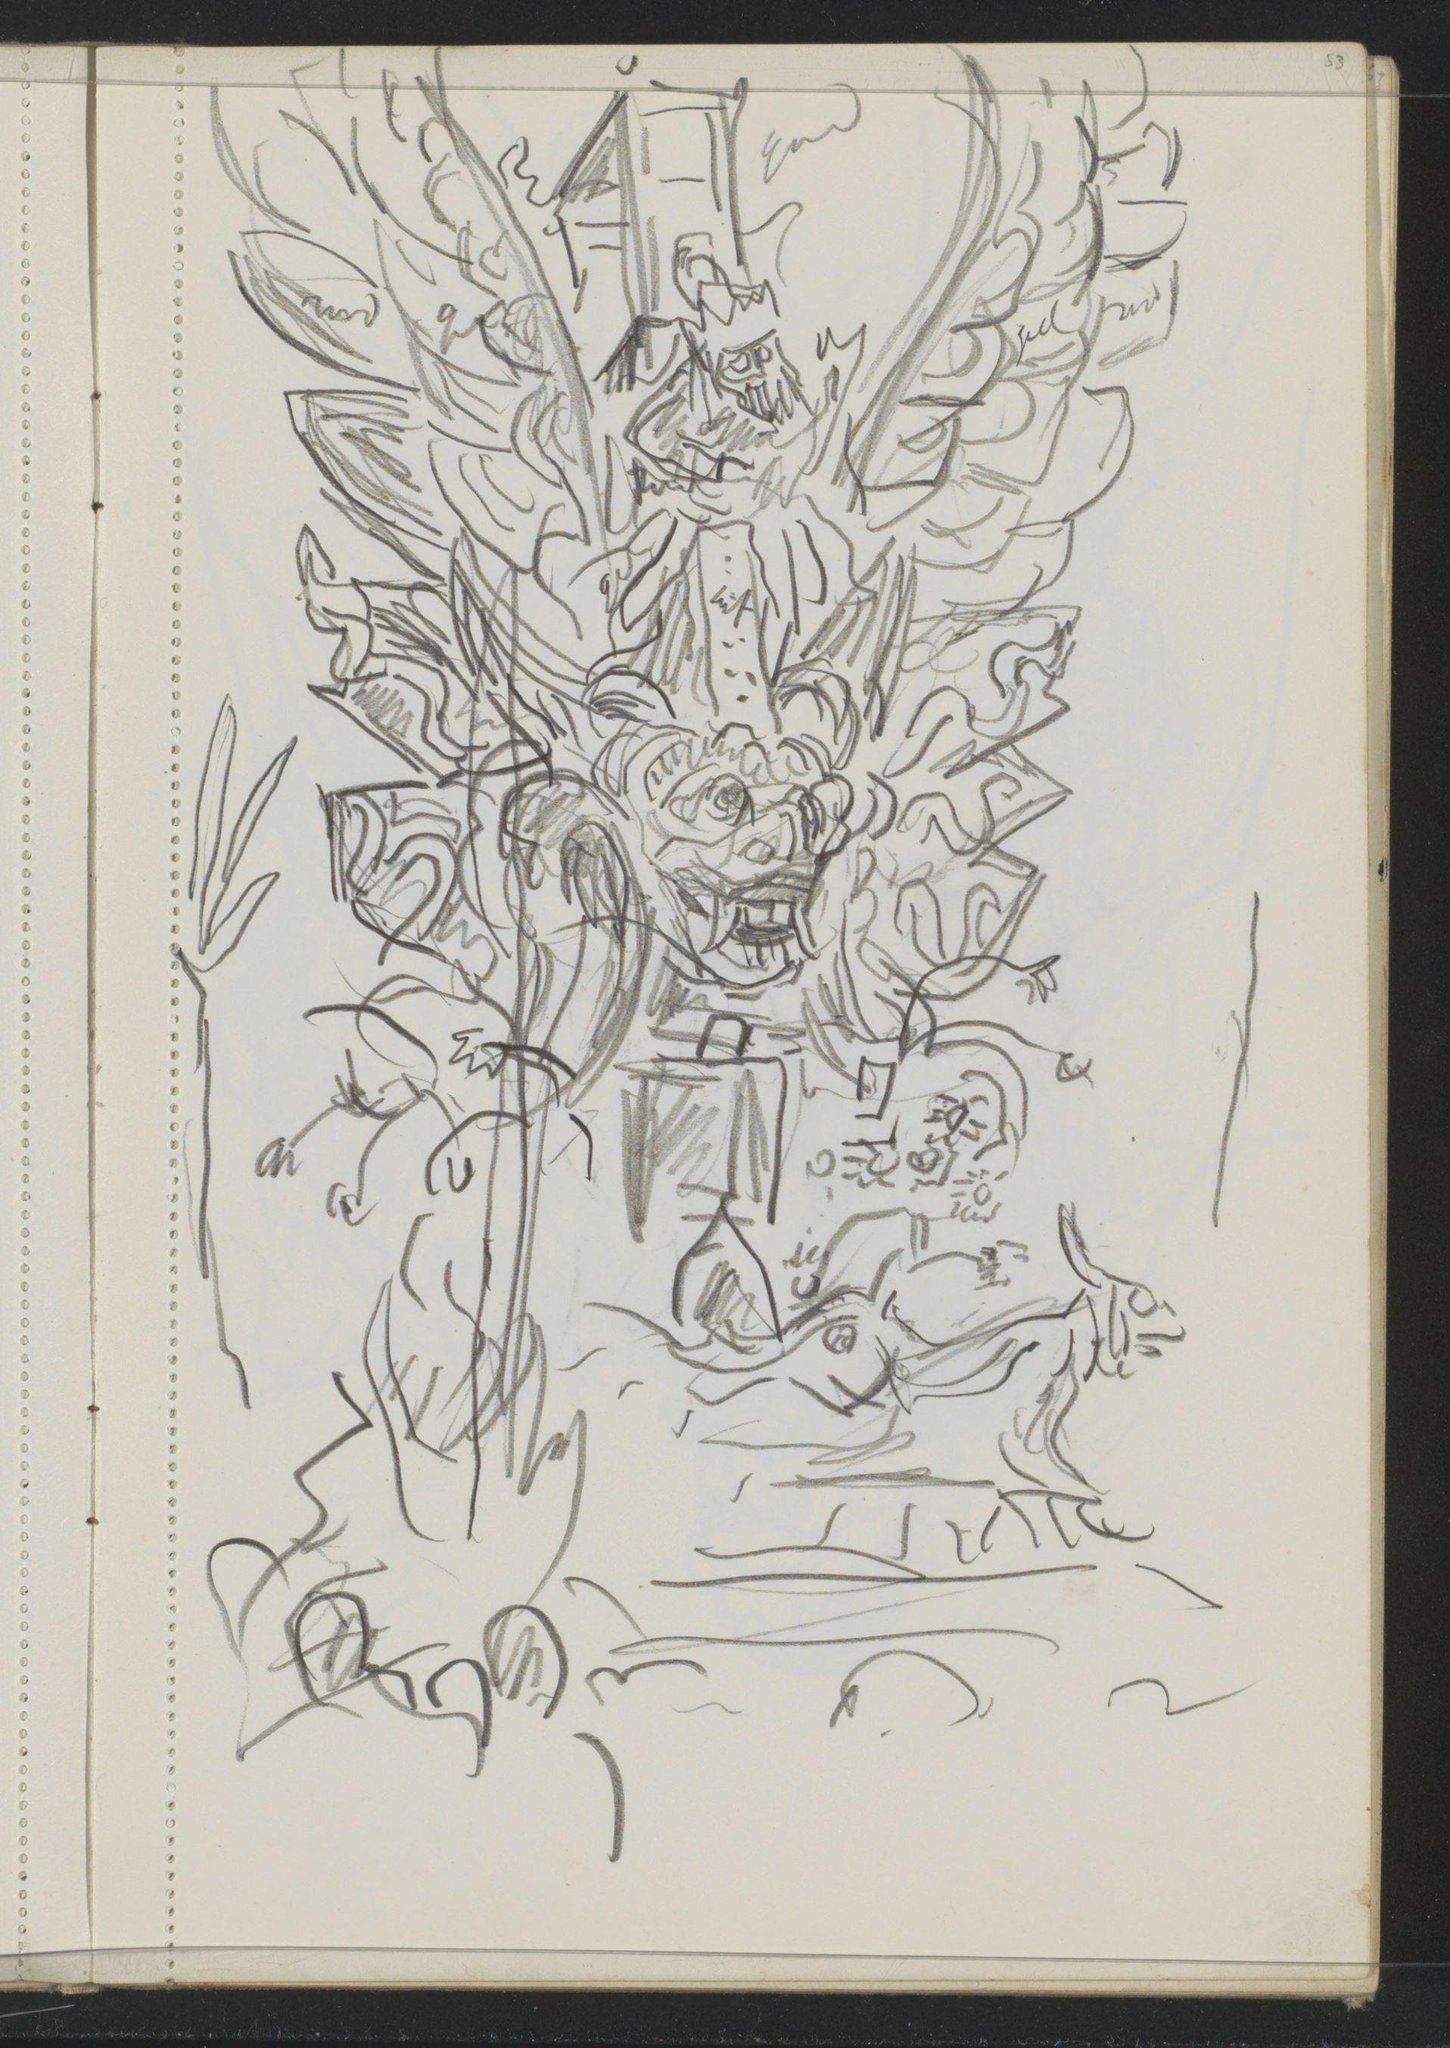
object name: sketchbook leaf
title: Crematietoren in de vorm van een draak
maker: marius bauer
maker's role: draughtsman, print maker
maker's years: 1867-1932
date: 1925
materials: paper, pencil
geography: indonesia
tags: funerary ritual, ancestor cult ~ hinduism, buddhism, jainism, dragon, architecture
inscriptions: kleurnotitie, handgeschreven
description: De toren wordt gebruikt in de rouwstoet voor een crematie. Pagina 53 uit een schetsboek met 74 bladen.